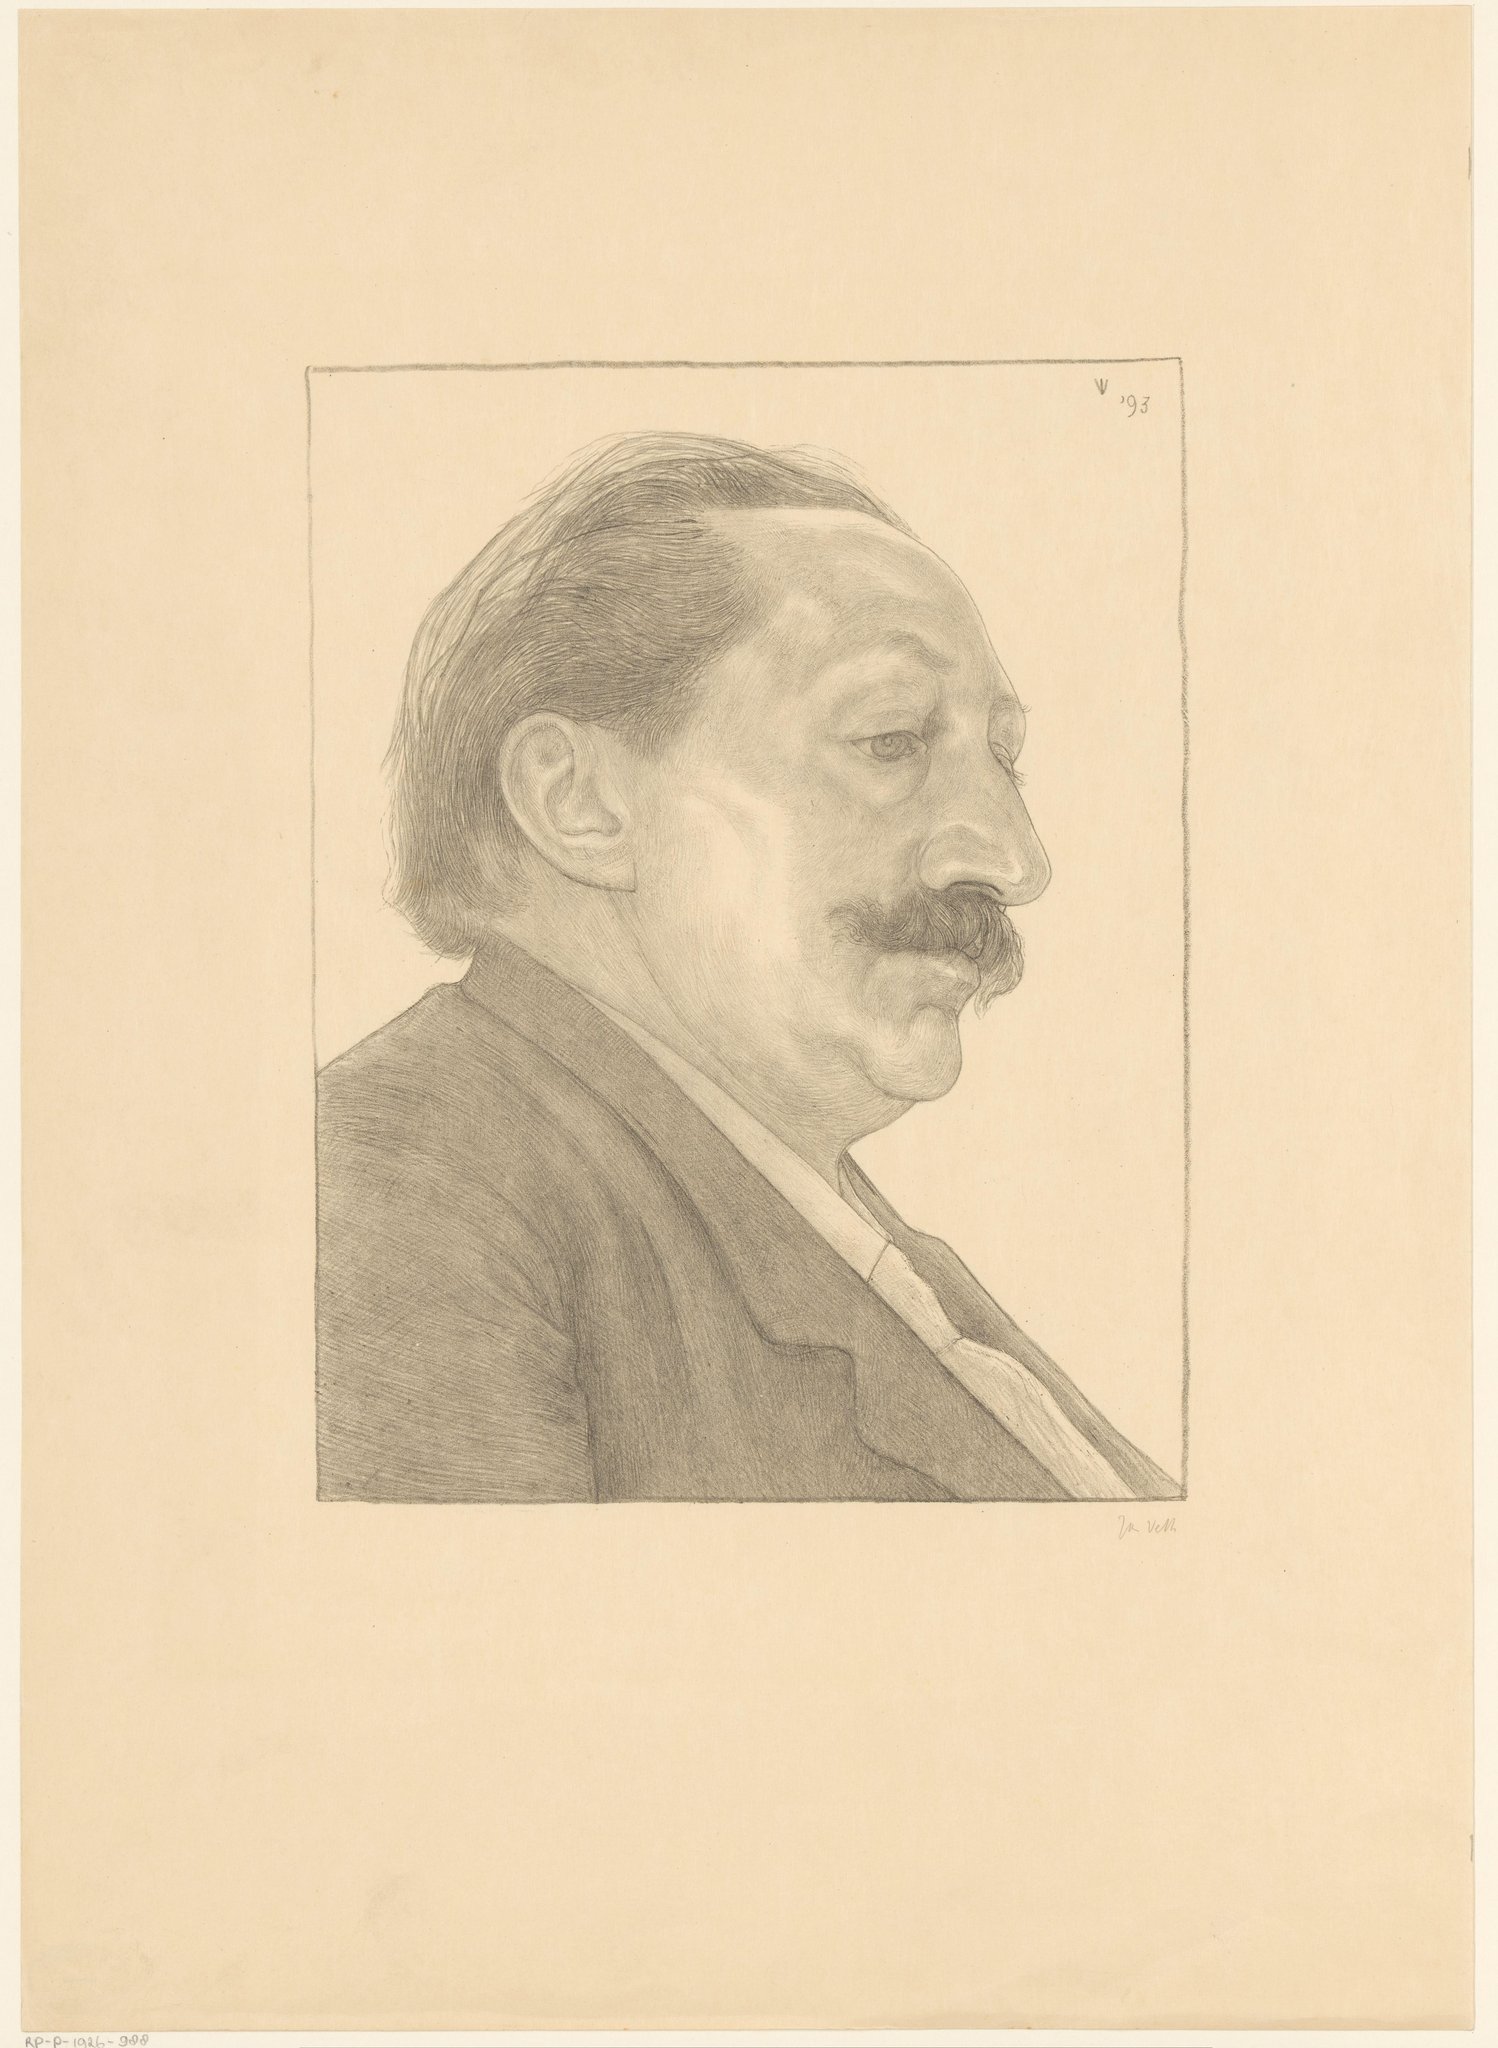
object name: print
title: Bekende tijdgenooten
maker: jan veth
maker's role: designer, draughtsman, painter, print maker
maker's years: 1864-1925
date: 1893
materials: paper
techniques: lithograph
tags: the hague, painter, draughtsman, willem maris, historical persons (+ (full) bust portrait)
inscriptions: inscription: ‘Jan Veth’, collector's mark: Lugt 2228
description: Deze prent werd uitgegeven bij De Amsterdammer op 17 december 1893.